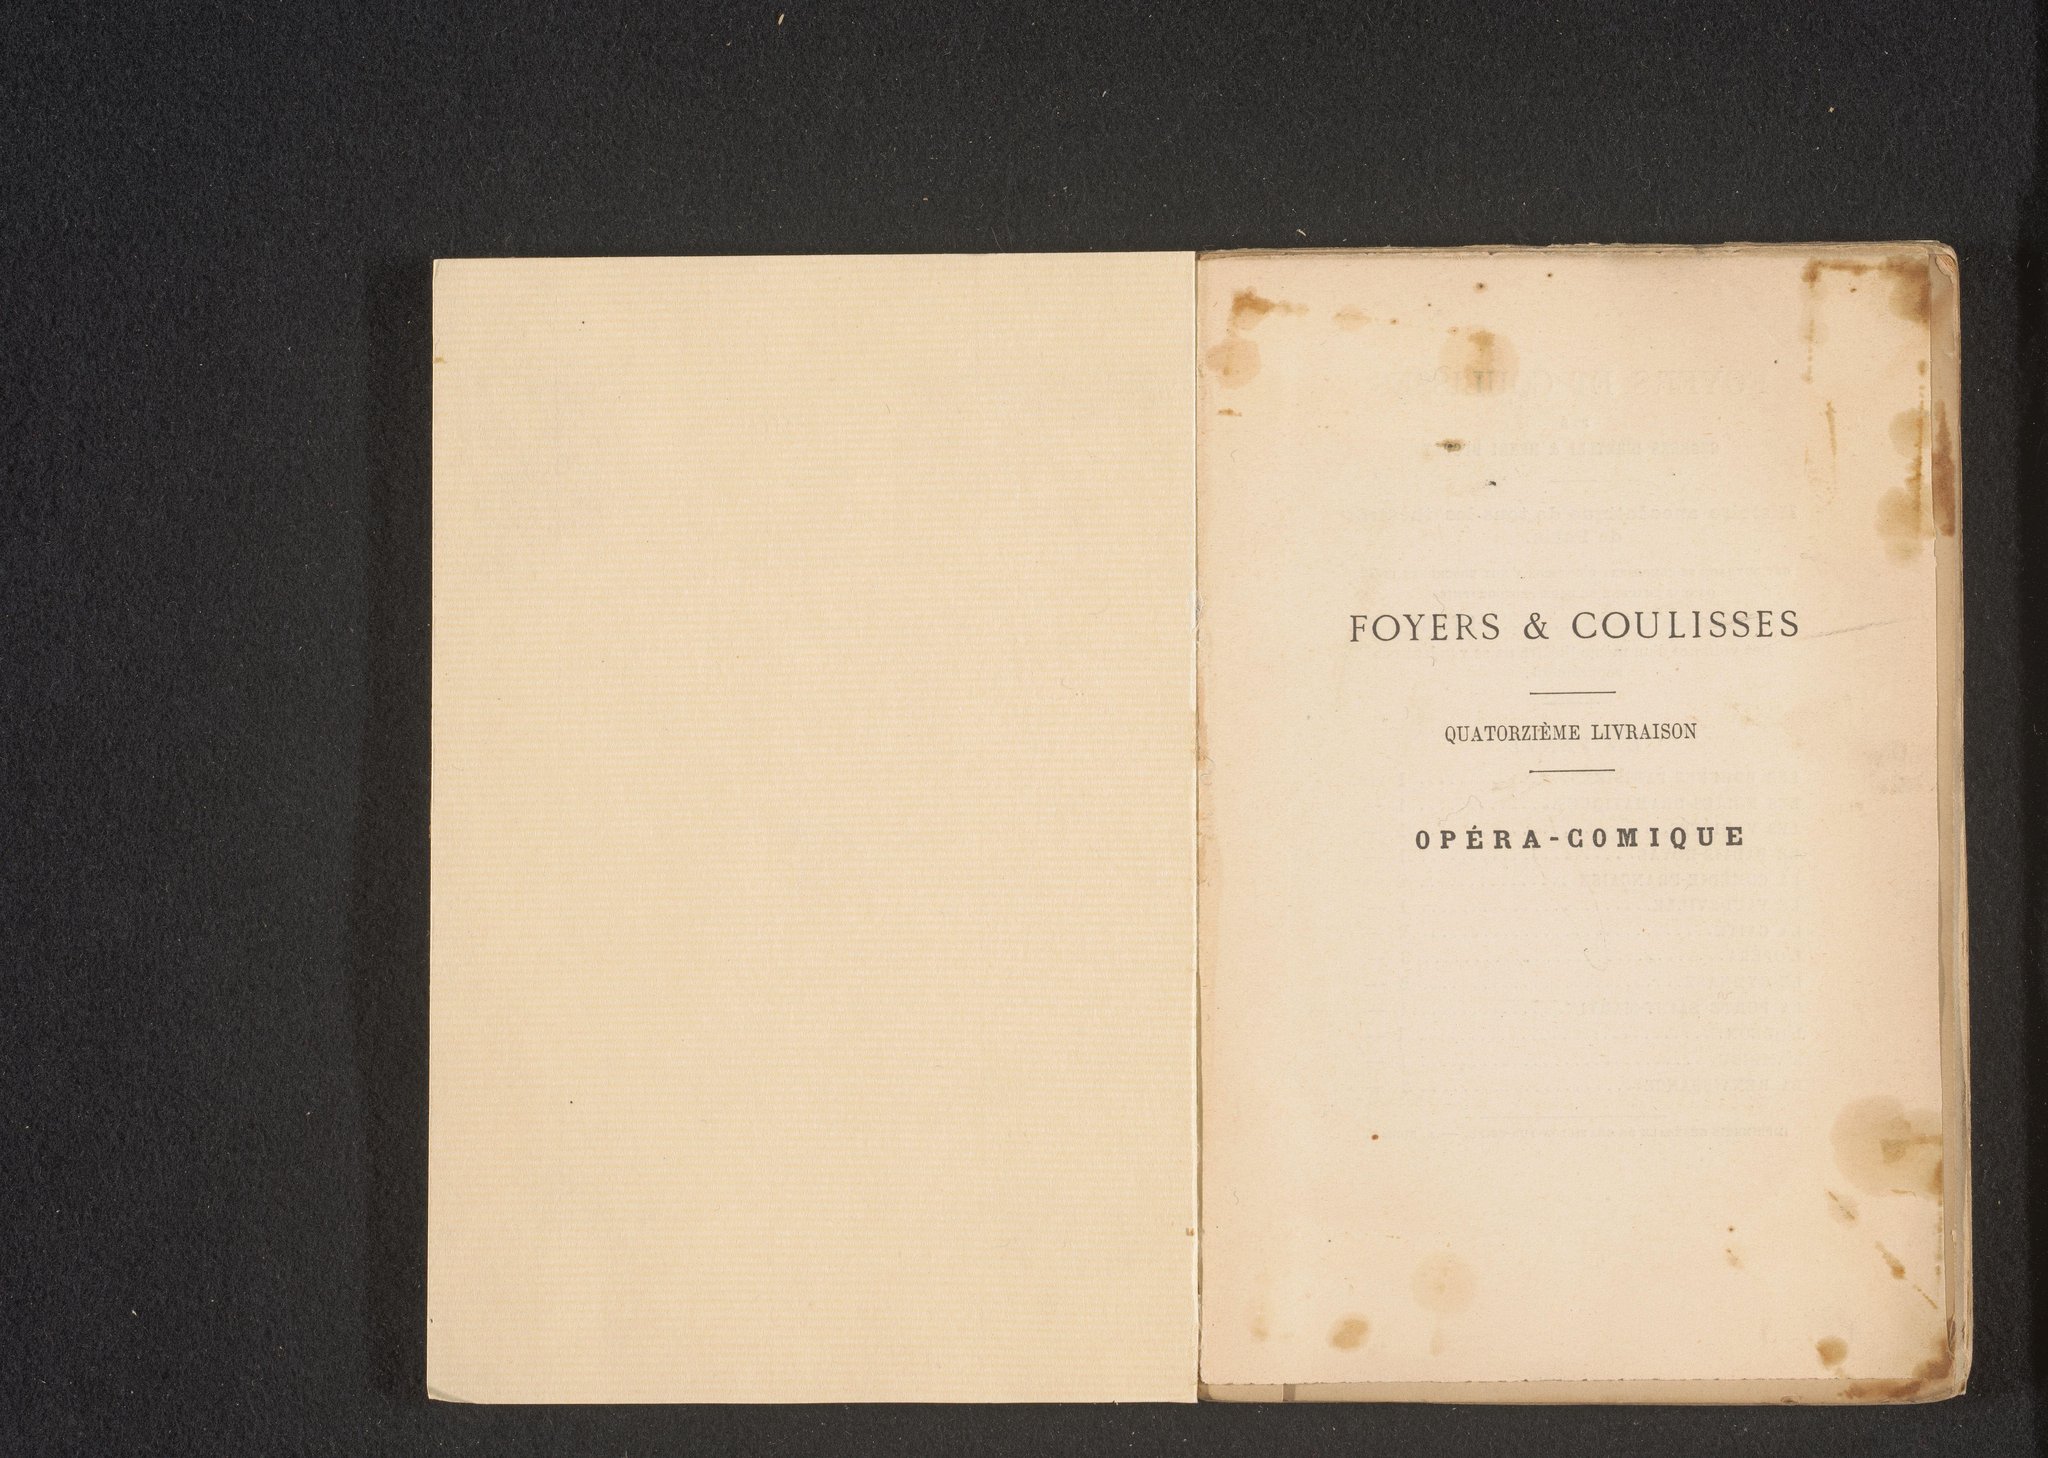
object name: book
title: Foyers et coulisses : histoire anecdotique des théatres de Paris : Opéra-Comique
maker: georges d heylli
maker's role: journalist, schrijver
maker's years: 1833-1902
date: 1885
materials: paper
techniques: woodburytype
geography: paris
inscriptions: number: ‘IIC 204.’